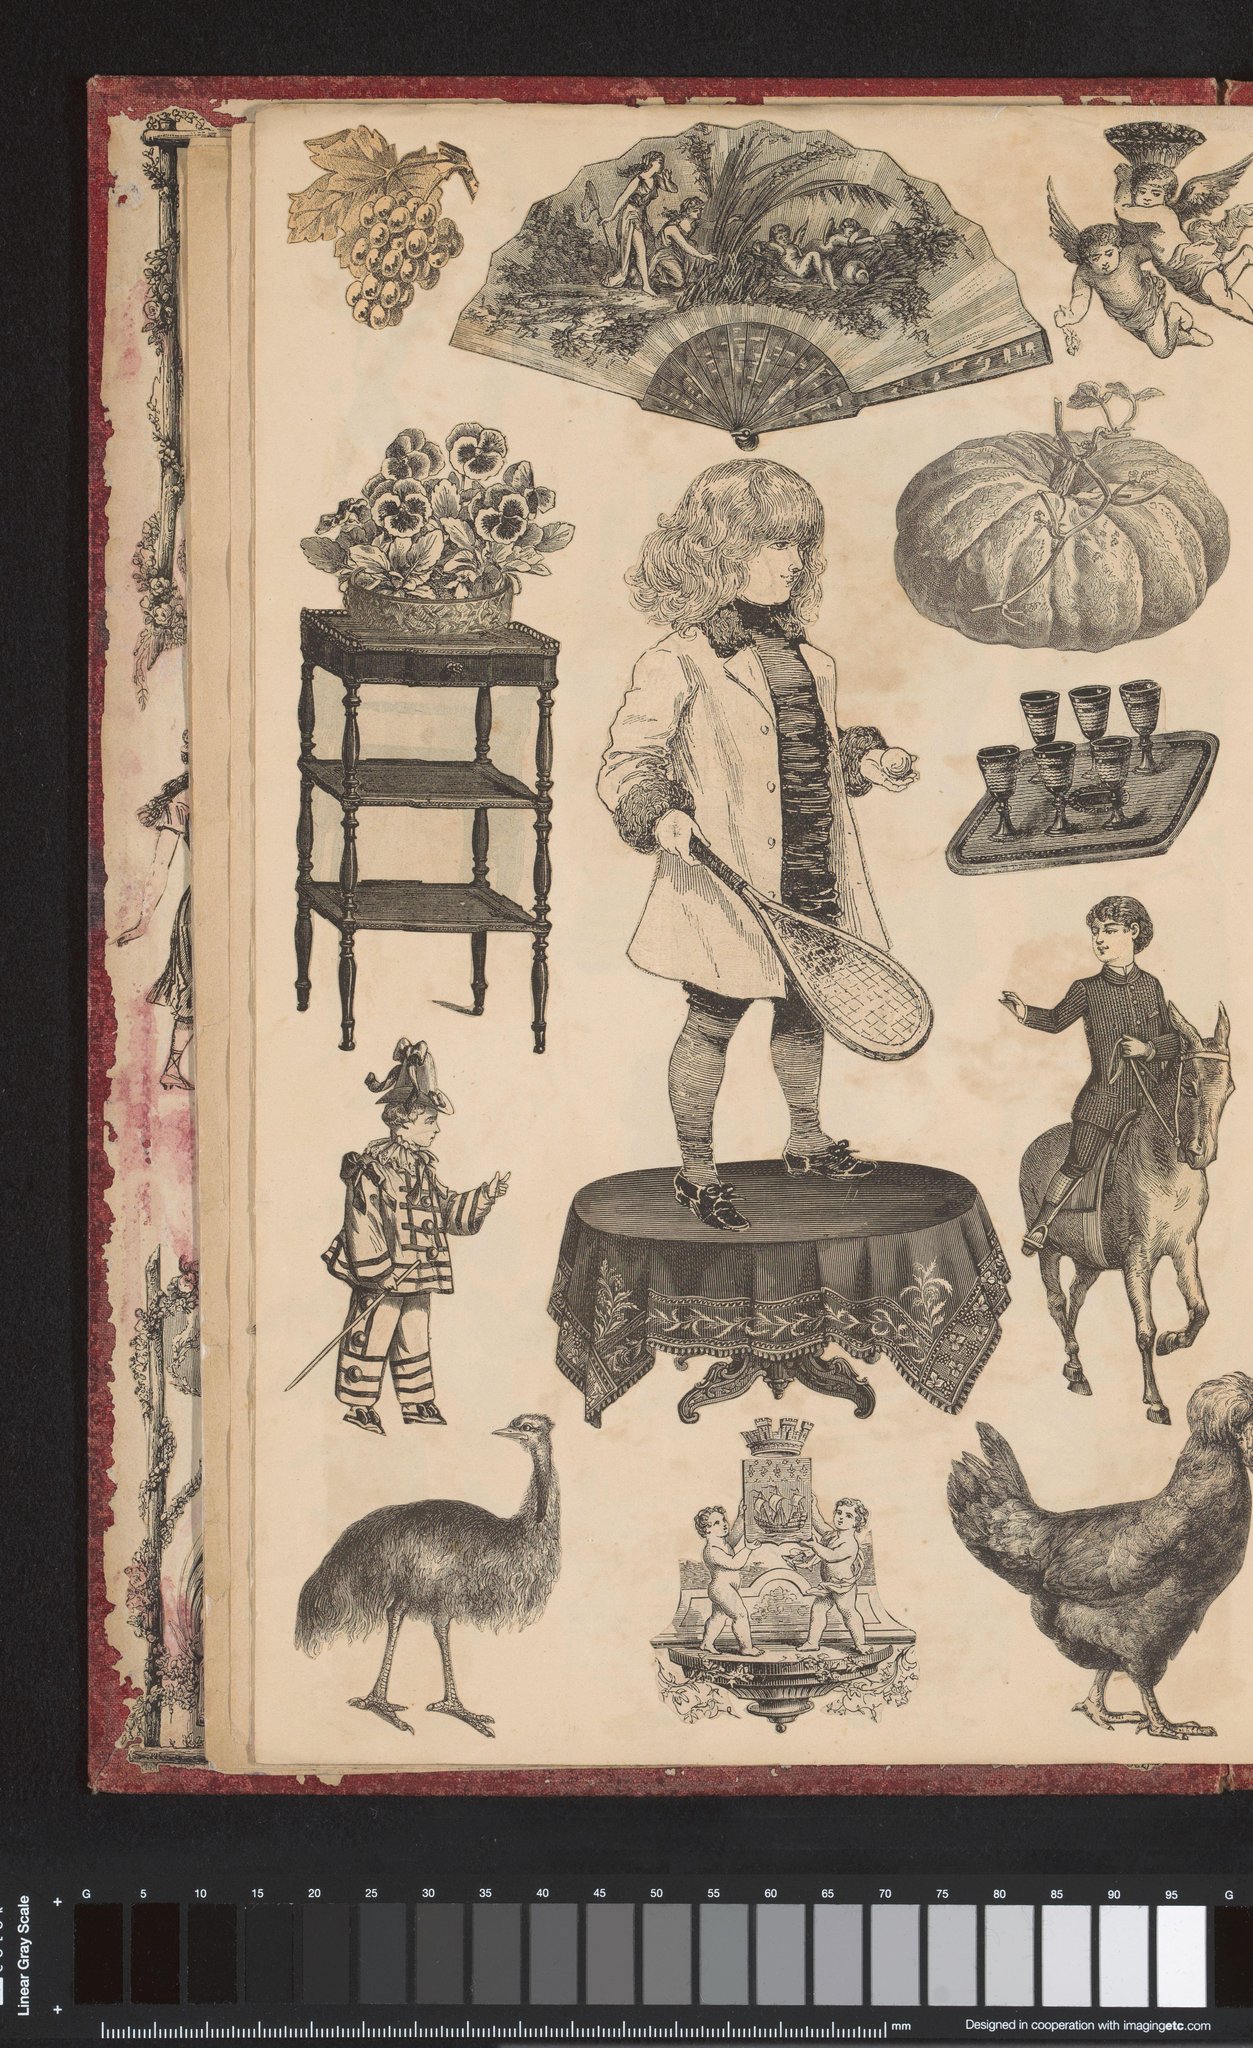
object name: print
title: Collage van uitgeknipte prenten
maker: Anonymous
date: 1870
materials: paper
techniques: engraving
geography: paris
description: Collage van uitgeknipte prenten. Onderdeel van een album met 32 bladen, aan beide zijden beplakt met uitgeknipte prenten, vermoedelijk afkomstig uit 19e-eeuwse tijdschiften.